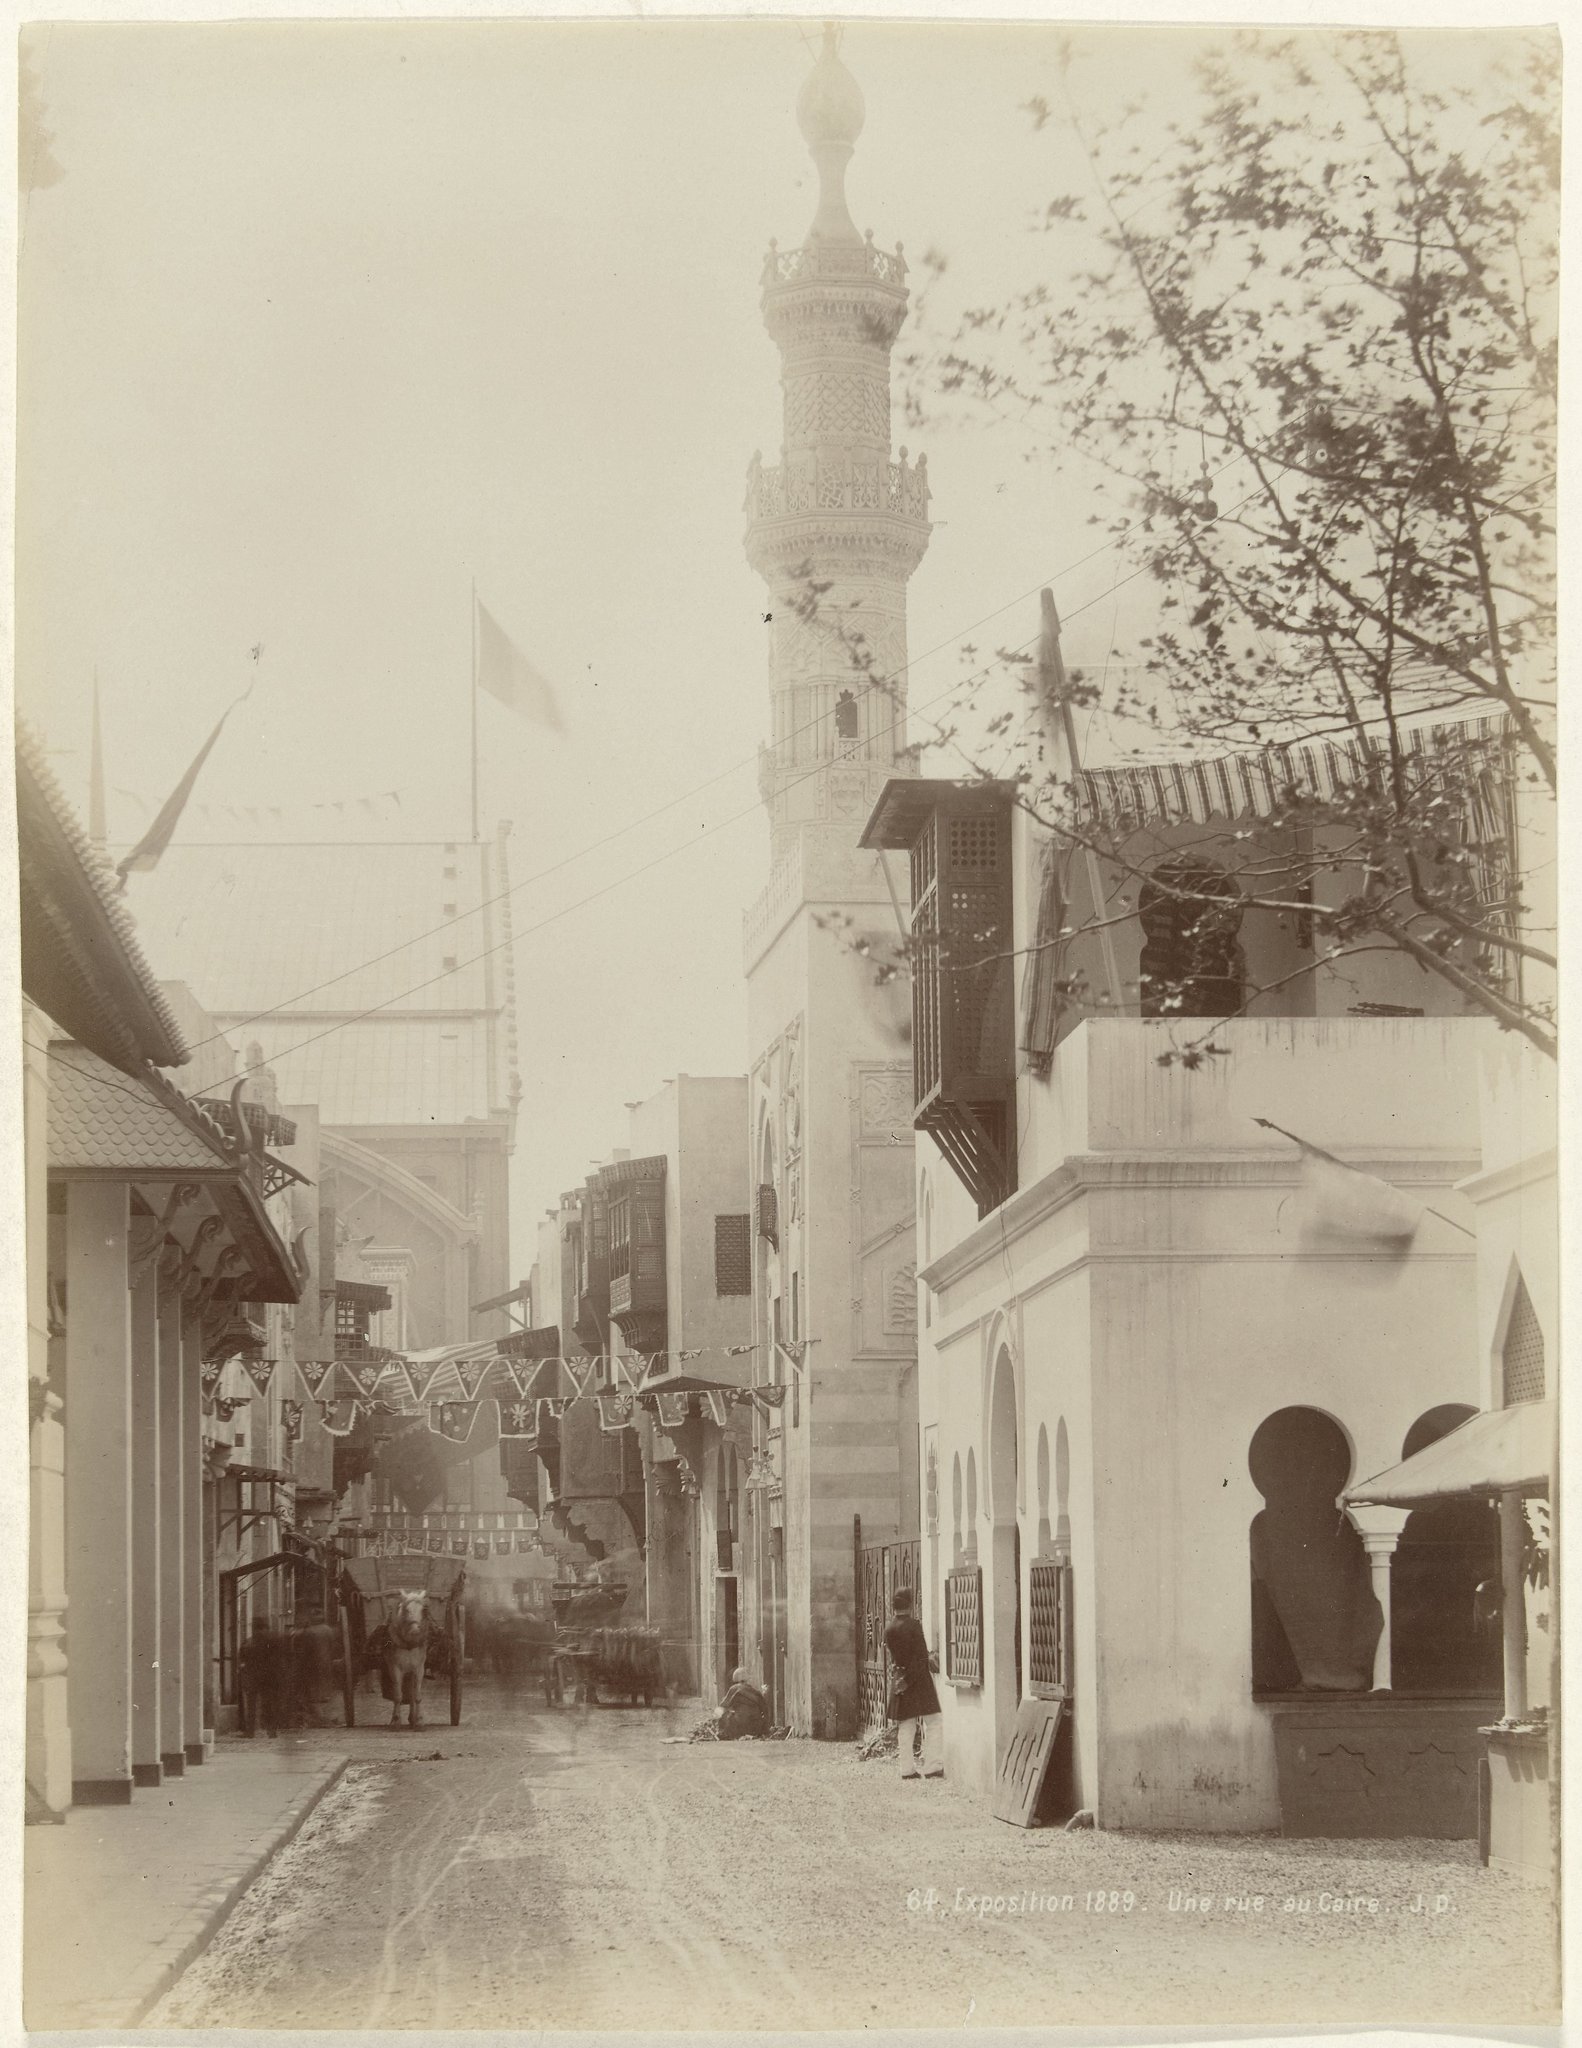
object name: photograph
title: Exposition 1889. Une rue au Caire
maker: jd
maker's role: fotograaf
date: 1889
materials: cardboard, paper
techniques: albumen print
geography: paris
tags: world fair, world exhibition, street, paris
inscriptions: number: ‘14’, inscription: ‘61. Exposition 1889. Une rue au Caire. J.D.’